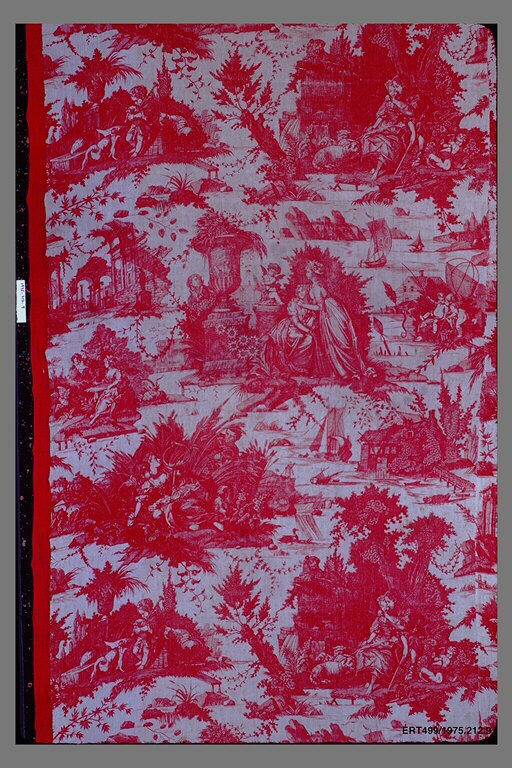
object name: panel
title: "L'Art d'Aimer"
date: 1788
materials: cotton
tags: women,trees